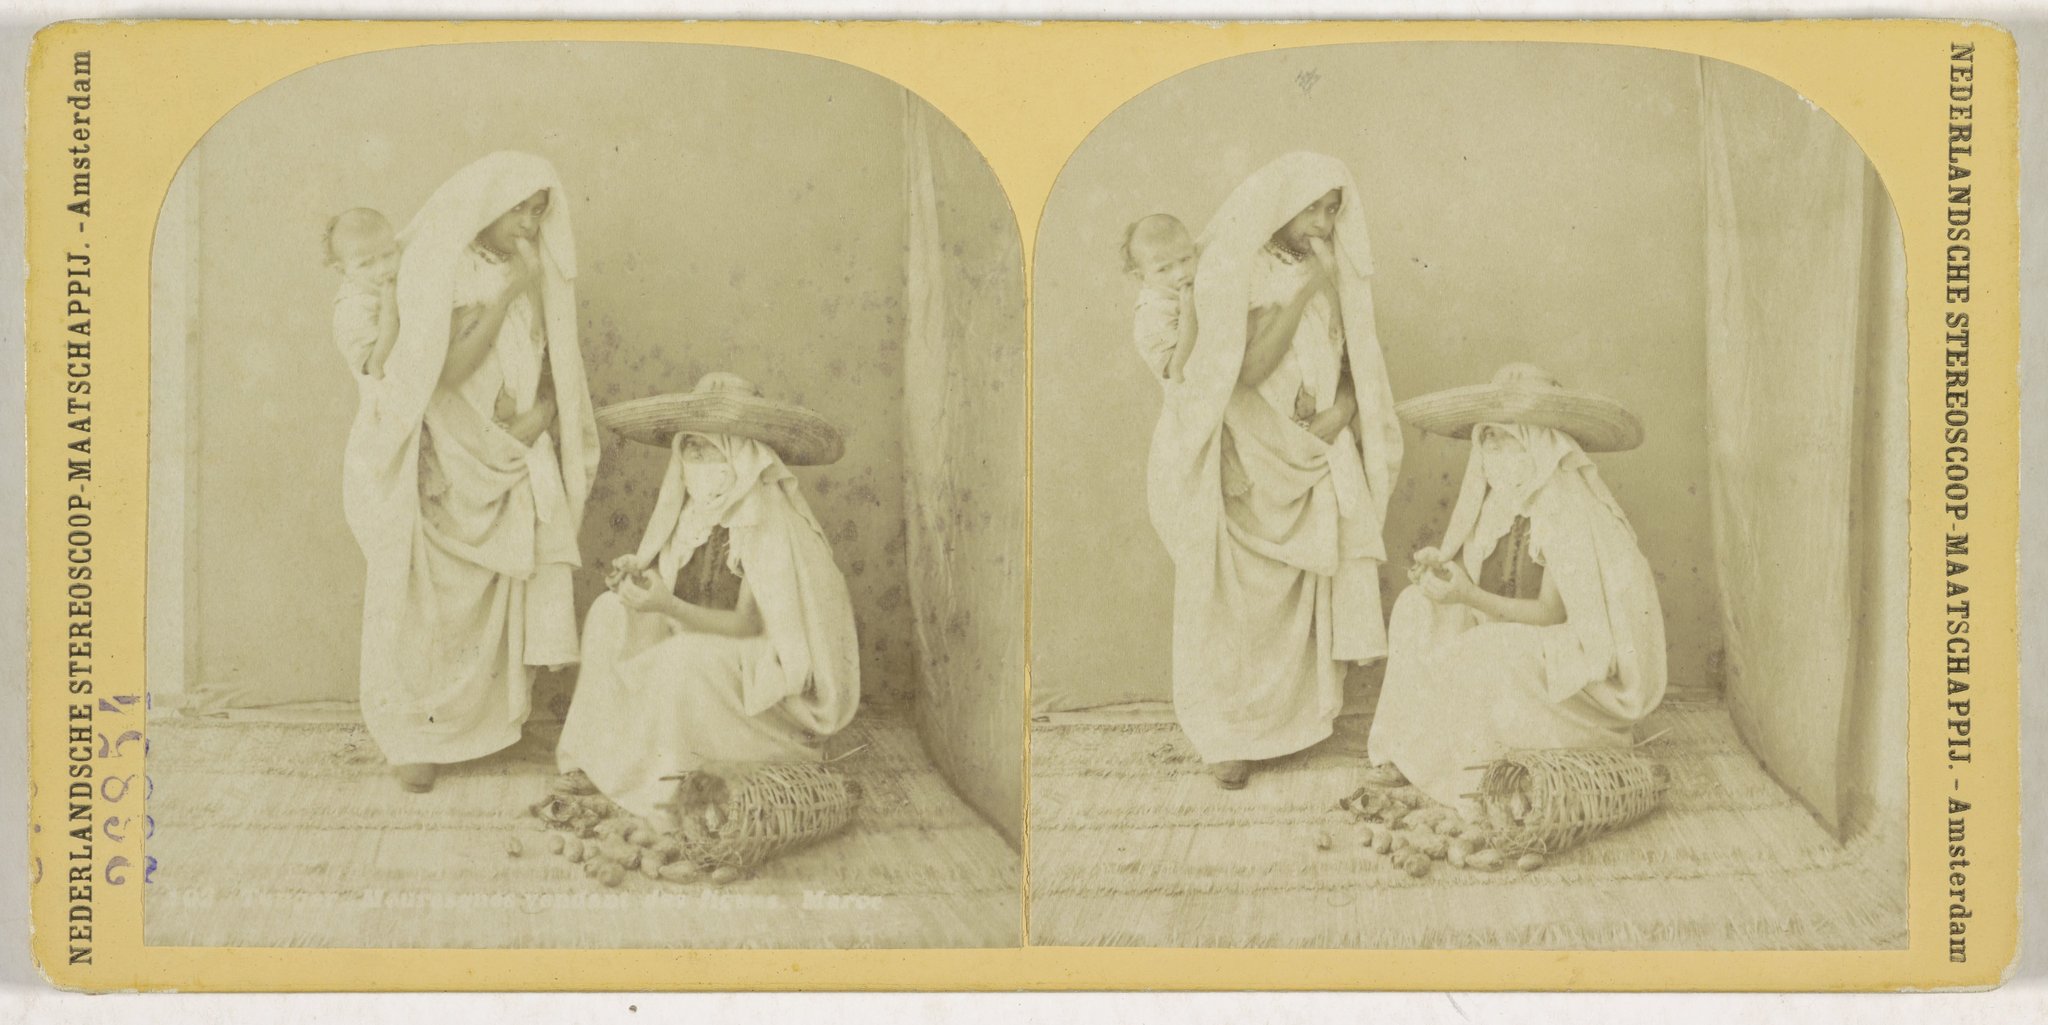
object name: stereograph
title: Vijgenverkoopster, Tanger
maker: j.g. beers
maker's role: fotograaf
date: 1879-1910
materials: cardboard, paper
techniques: albumen print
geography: tanger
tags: merchant, salesman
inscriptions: number: ‘26854’, number: ‘102.’